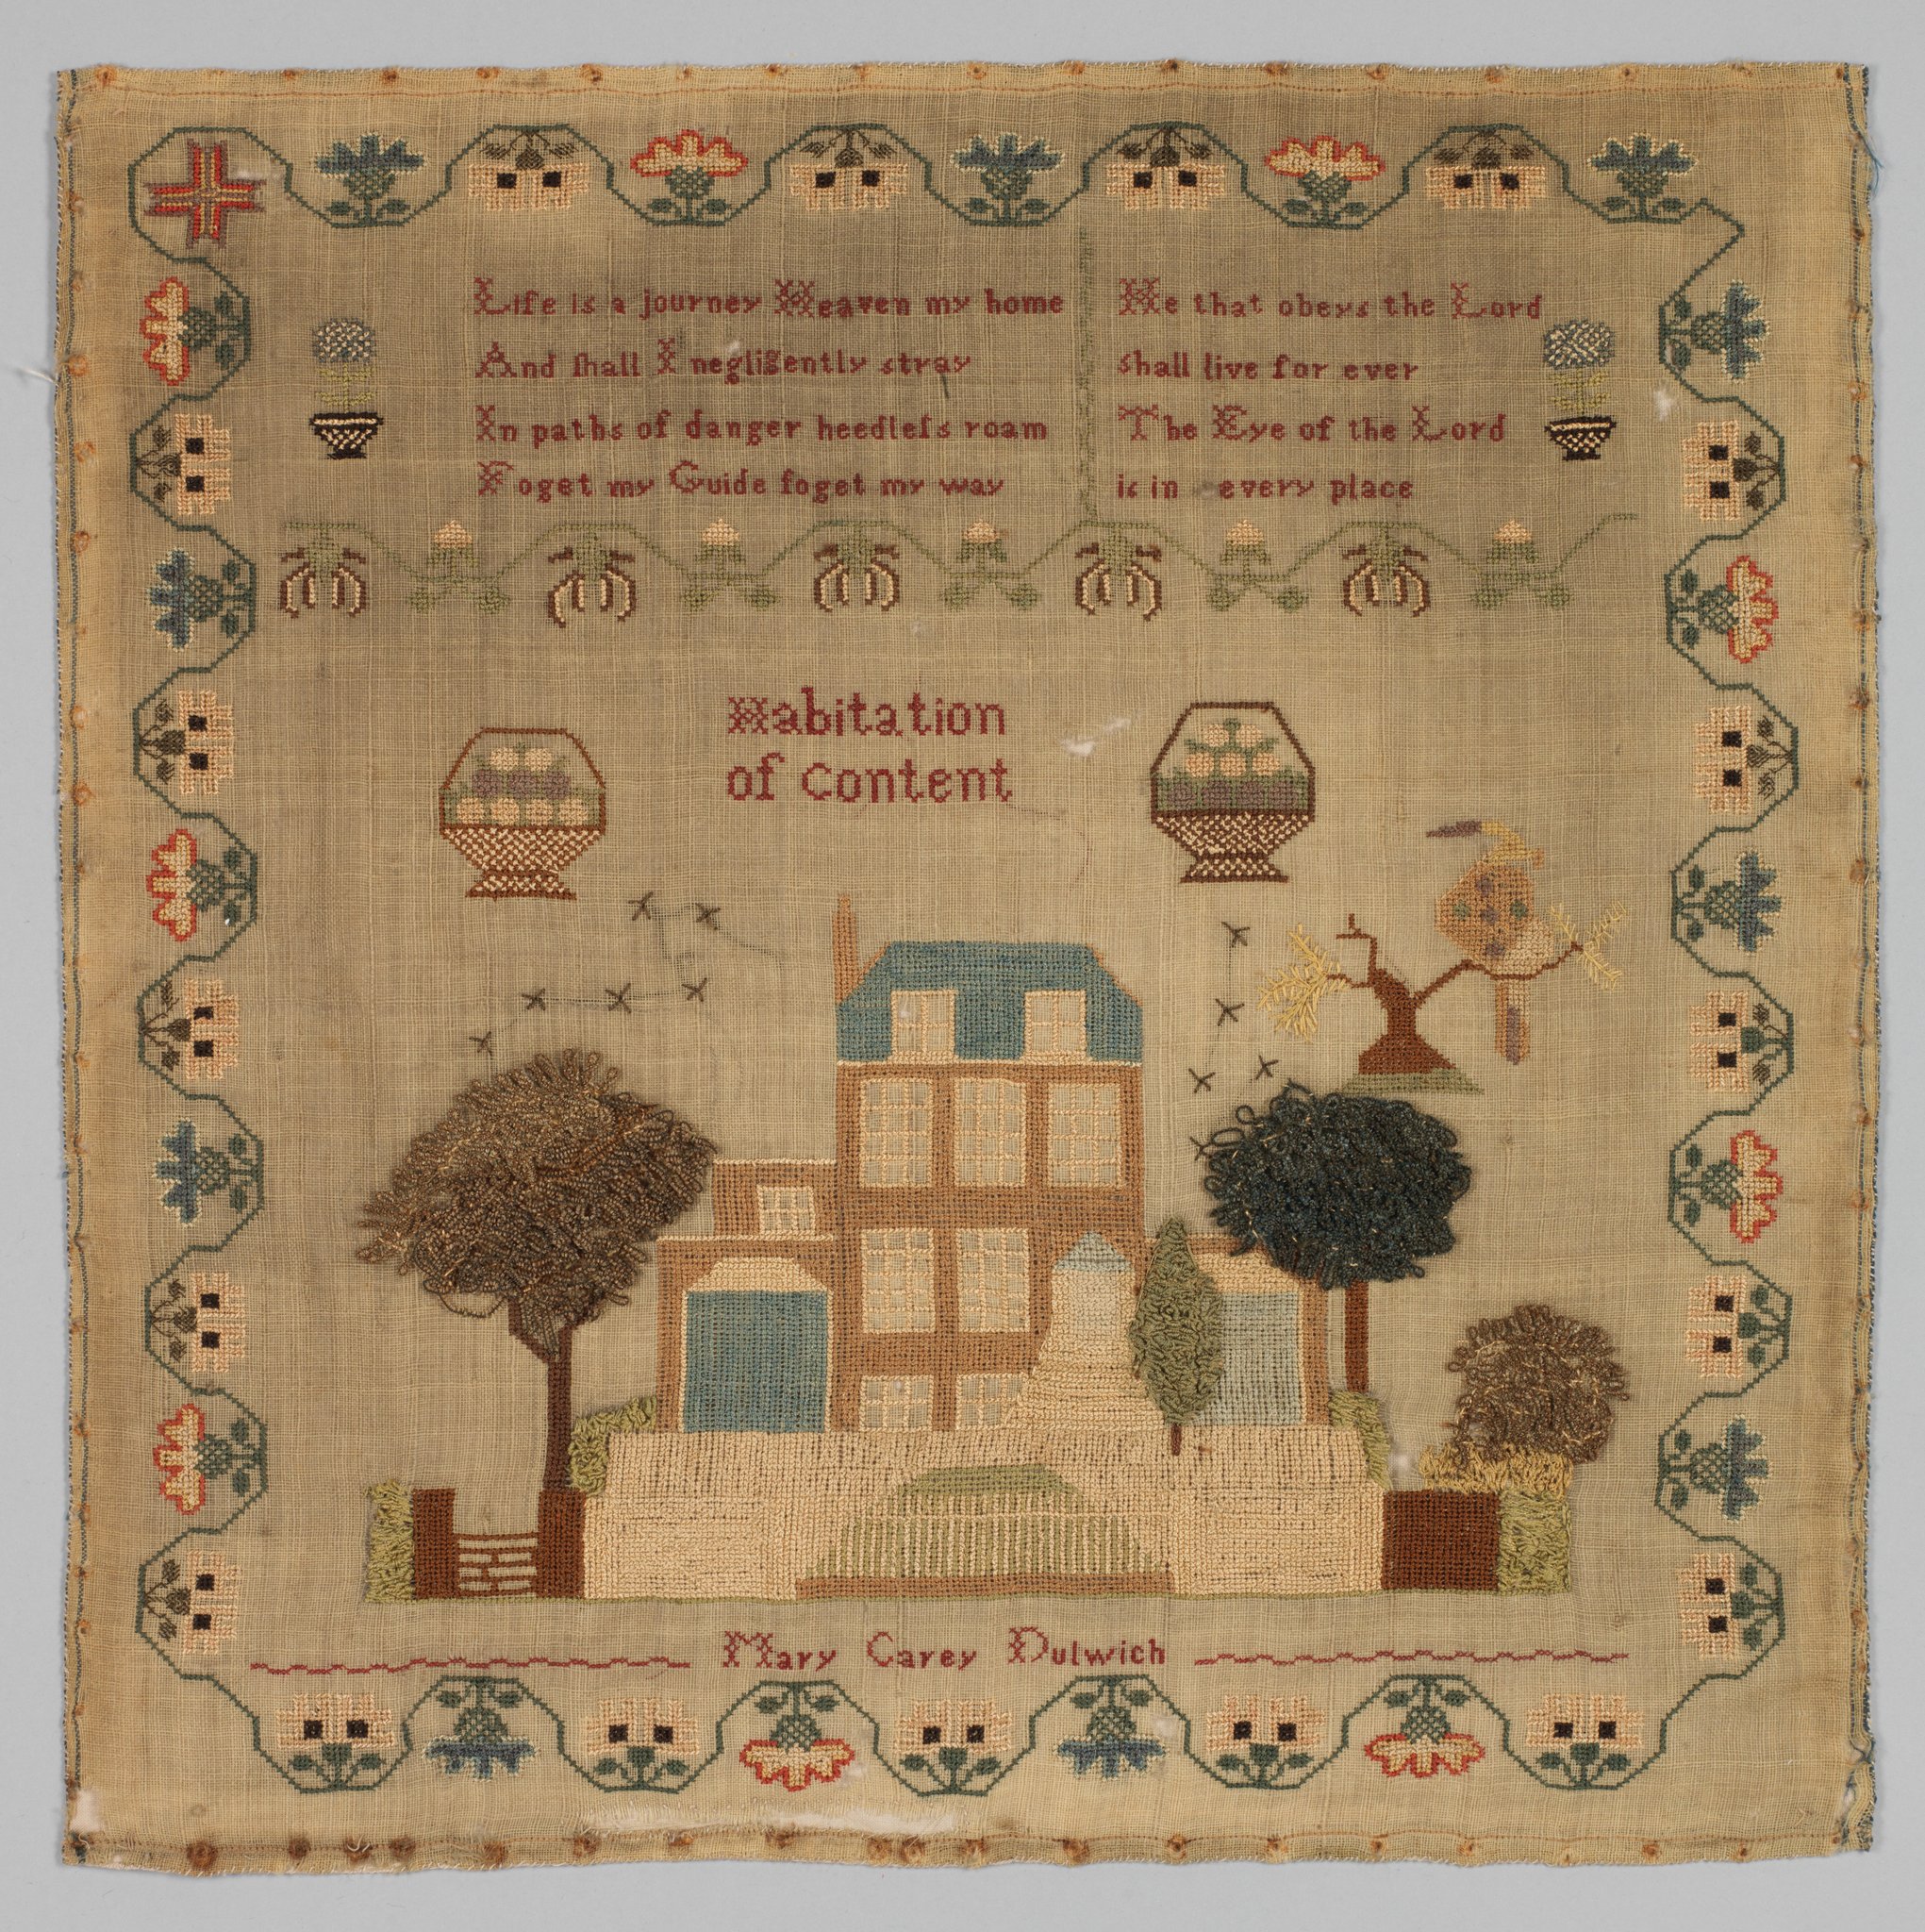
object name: sampler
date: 1801-1900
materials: canvas, silk, wool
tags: houses,trees